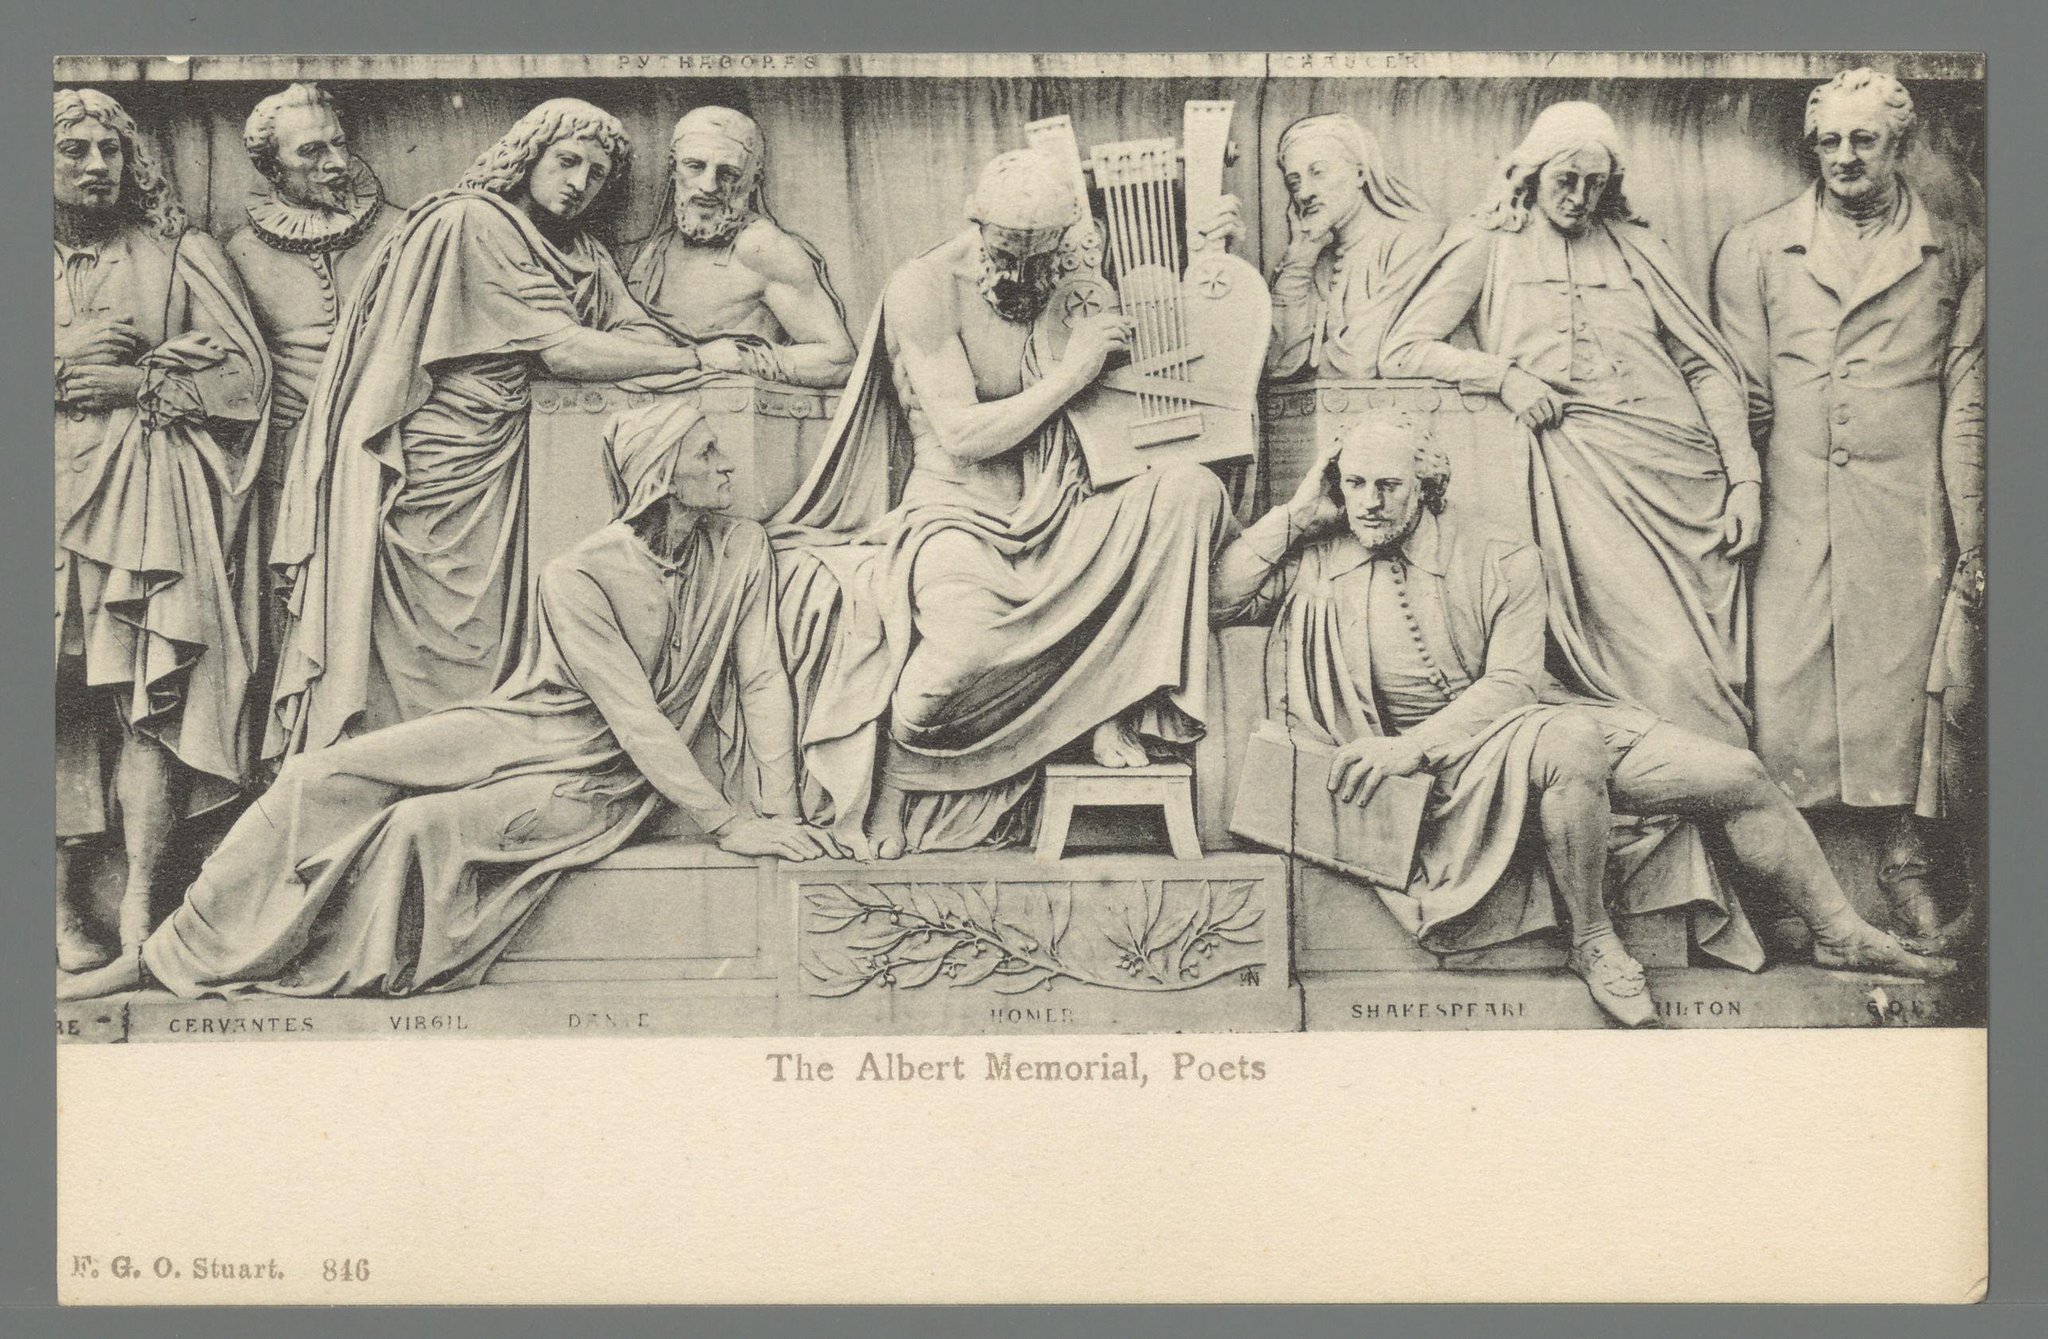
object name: photomechanical print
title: The Albert Memorial, Poets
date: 1902-1930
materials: cardboard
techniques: photograph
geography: germany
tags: william shakespeare, homerus, dante alighieri, publius vergilius maro, draughtsman, johann wolfgang von goethe, monument, statue, writer, poet, author